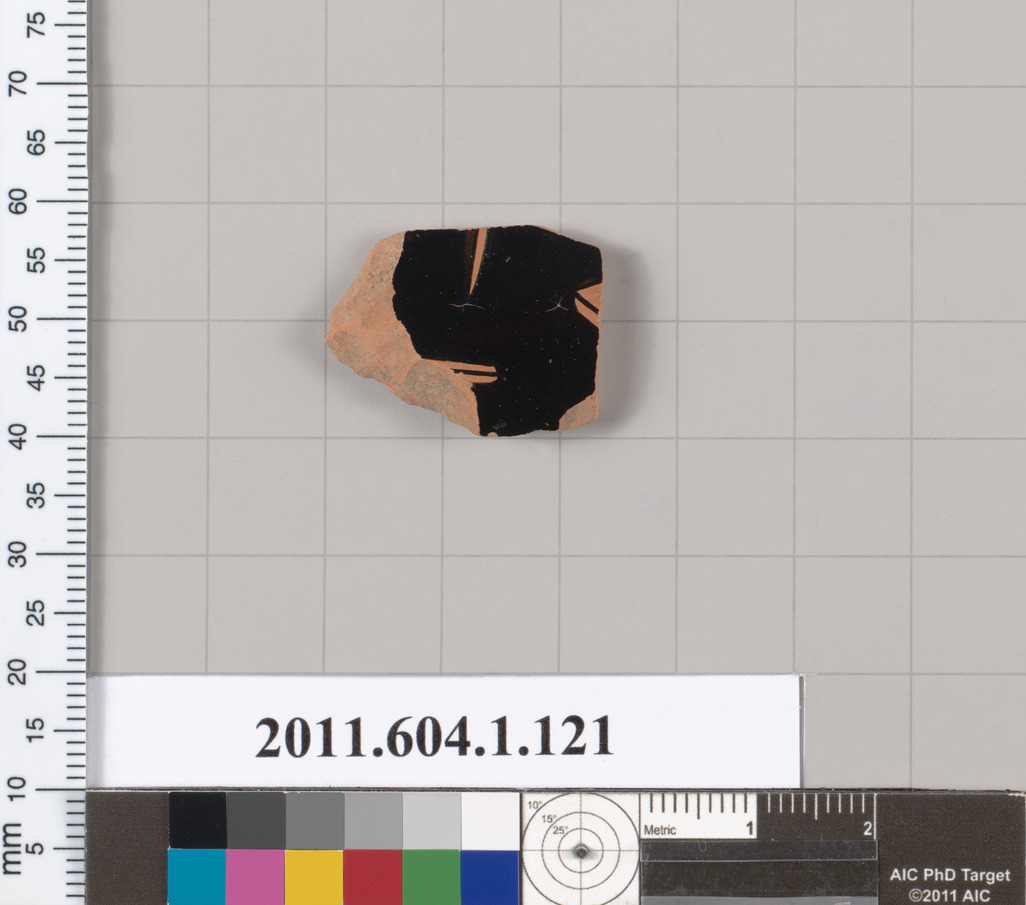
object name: kylix fragment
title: Terracotta fragment of a kylix (drinking cup)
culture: greek, attic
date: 470-450 BCE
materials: terracotta